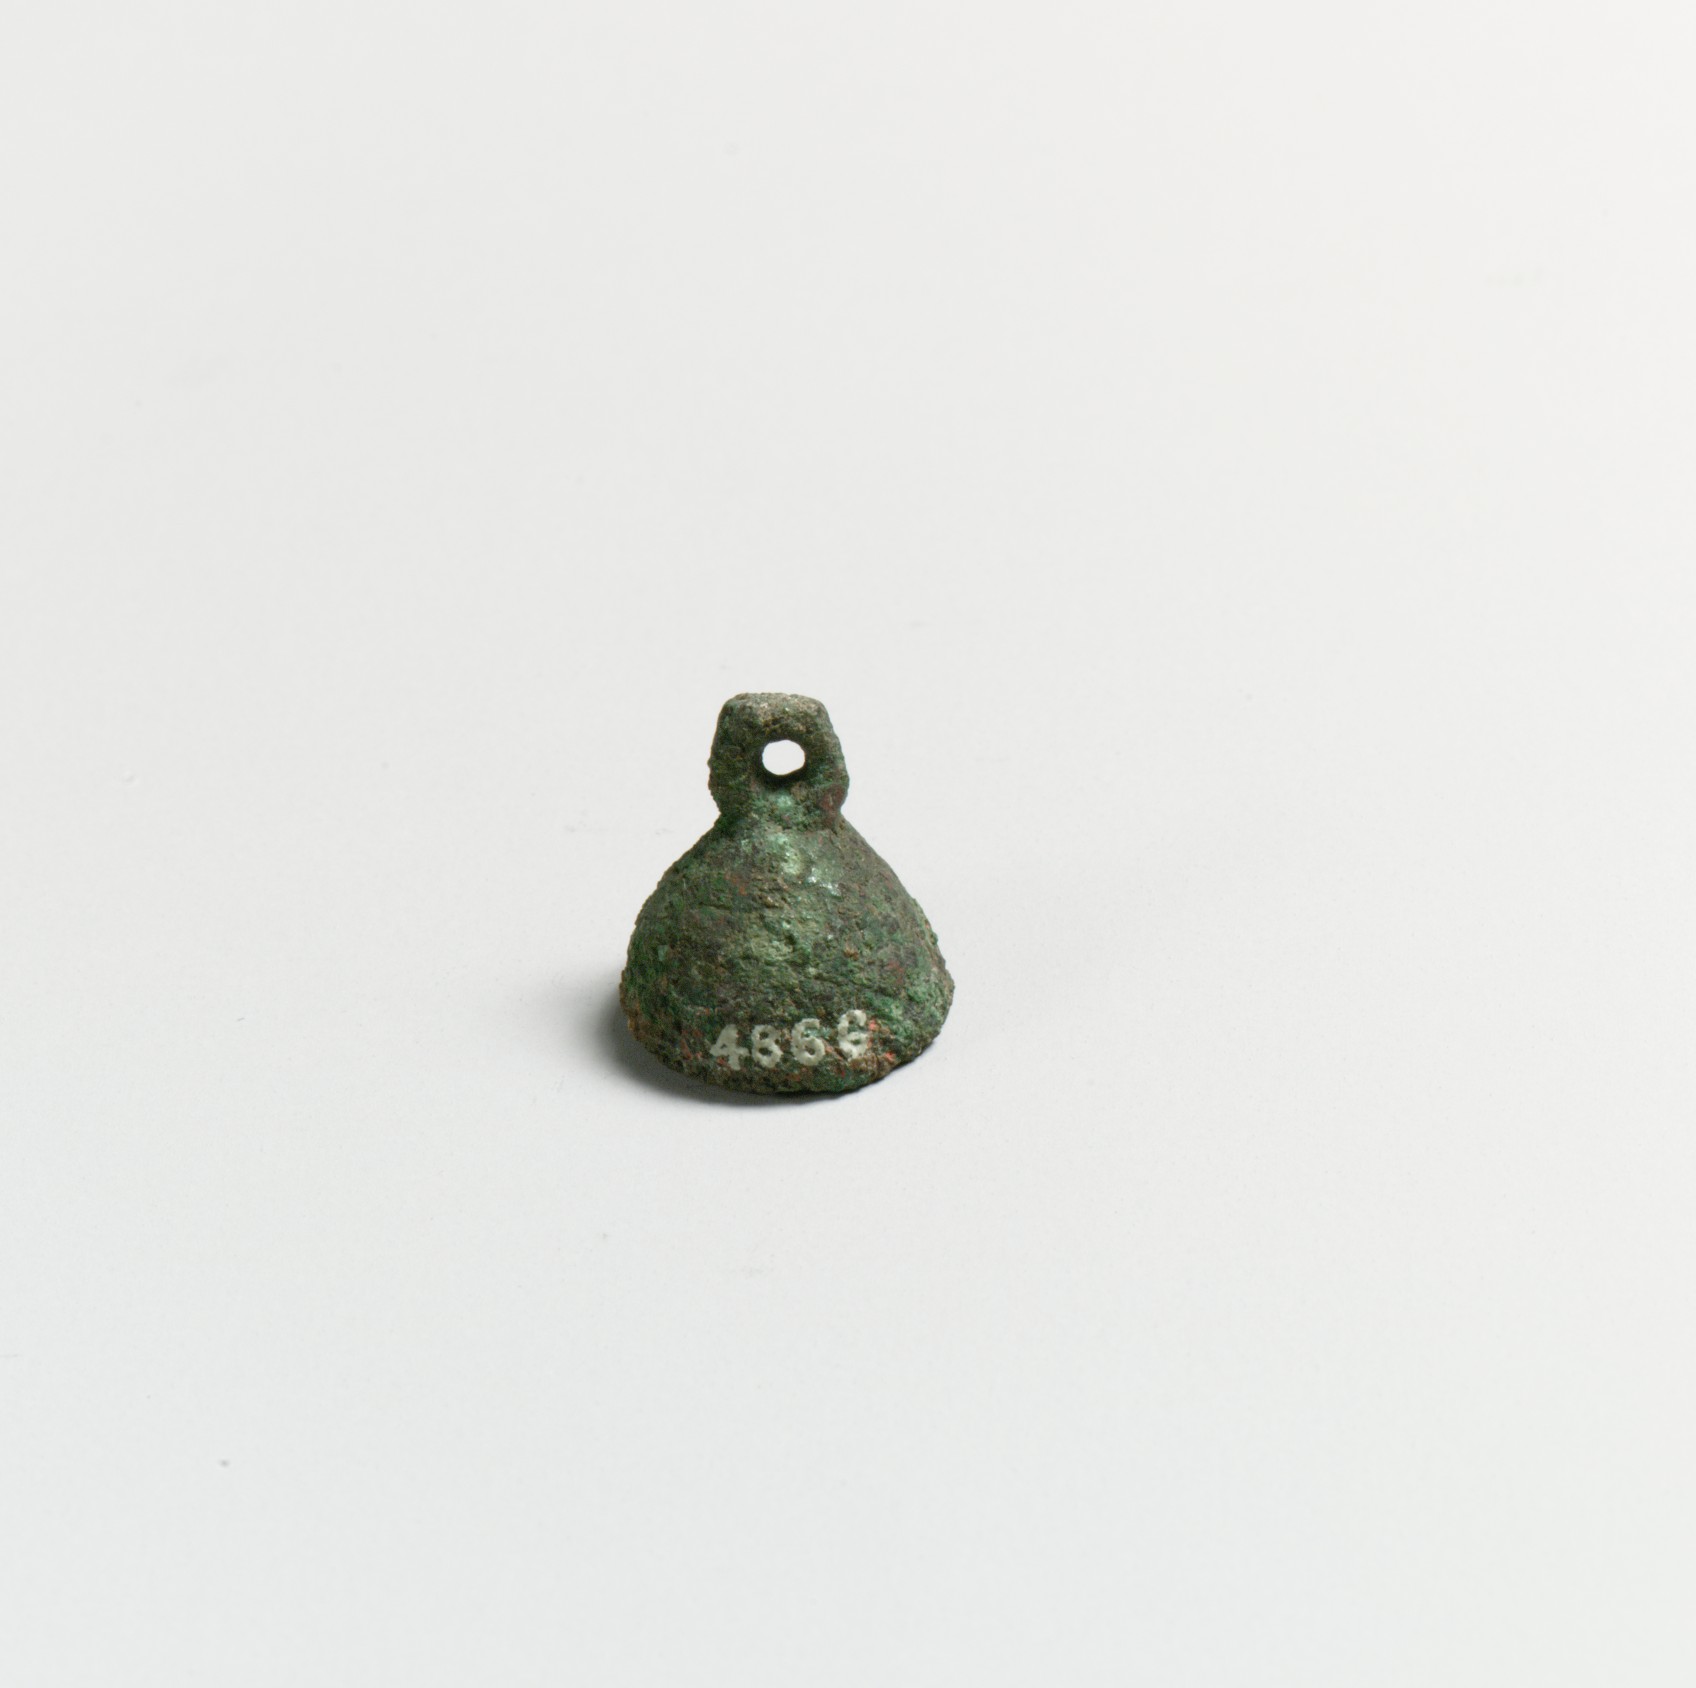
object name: bell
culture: cypriot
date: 400-301 BCE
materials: bronze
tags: musical instruments